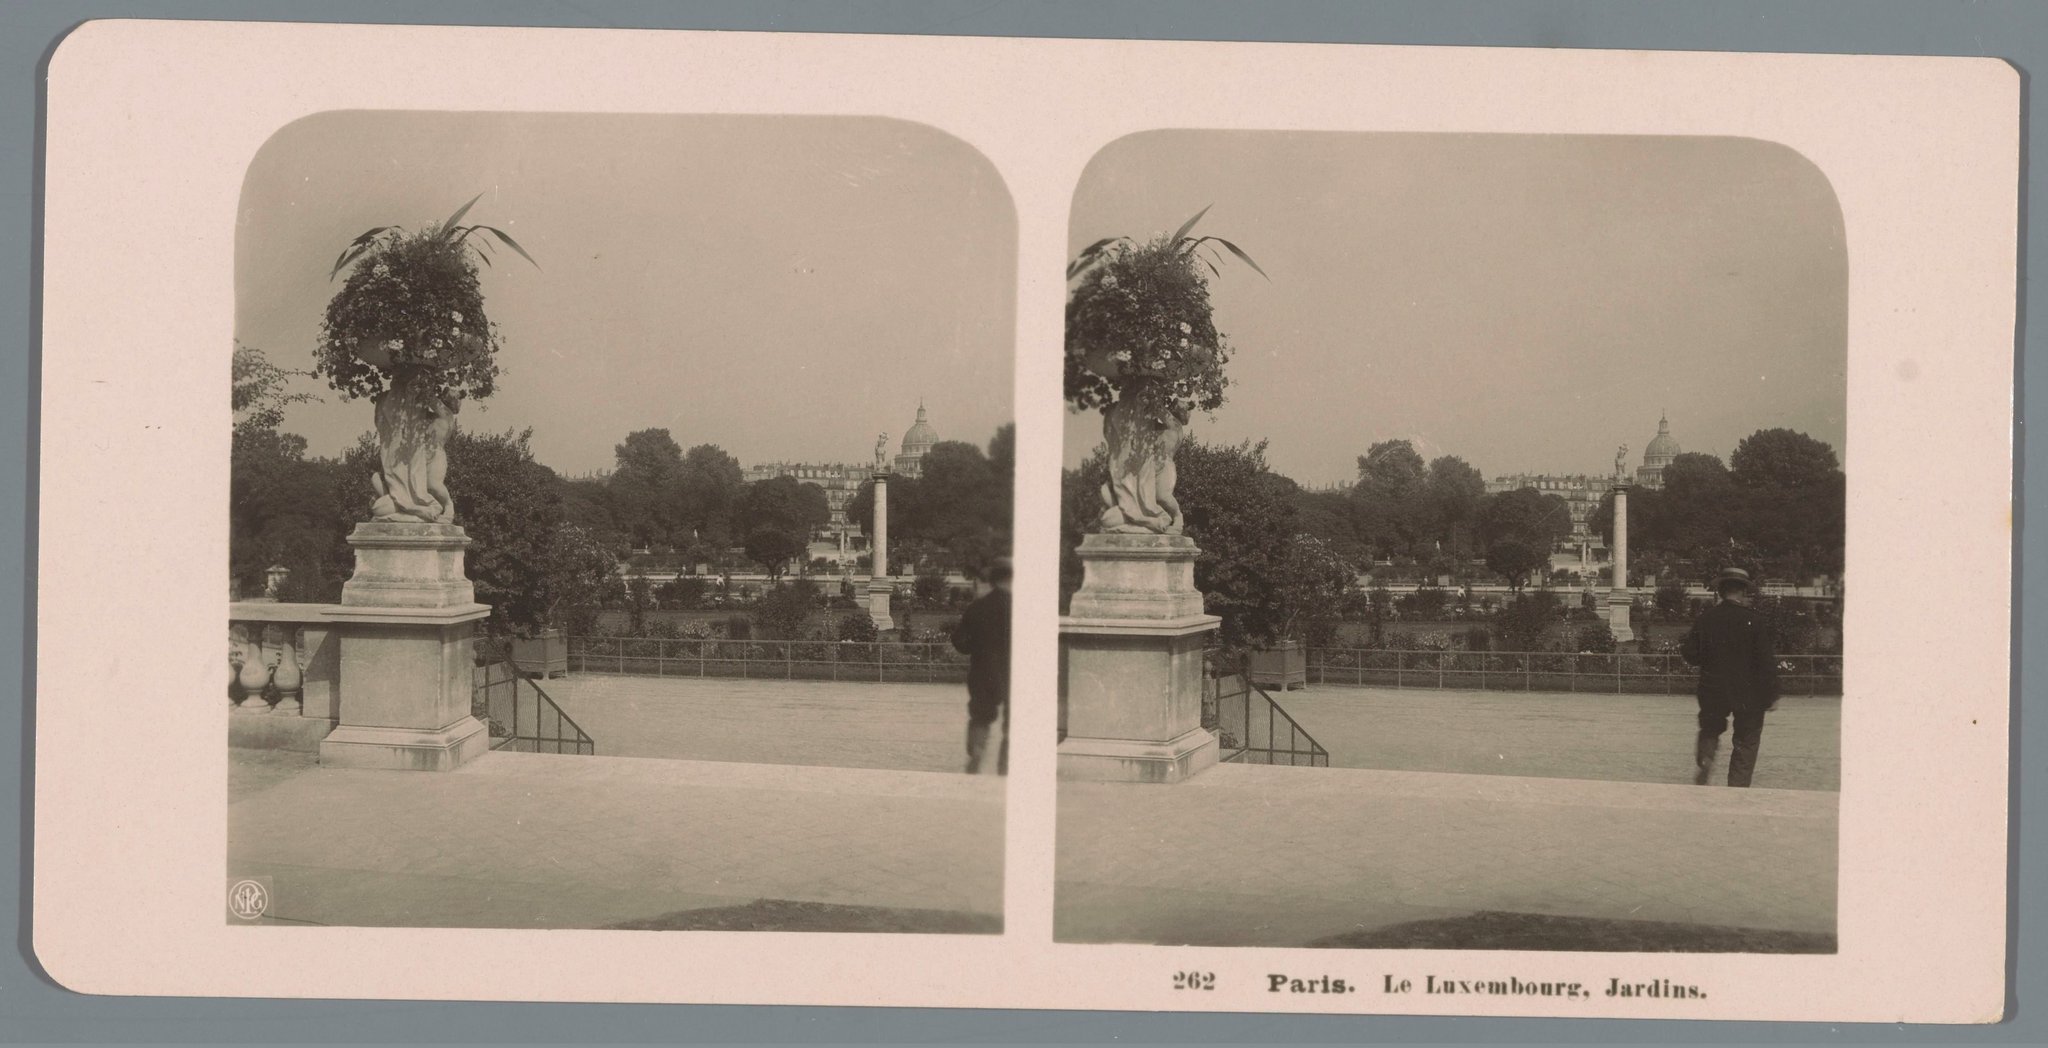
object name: stereograph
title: Gezicht op de Jardin du Luxembourg te Parijs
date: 1895-1905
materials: cardboard, photographic support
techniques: gelatin silver print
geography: paris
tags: park, garden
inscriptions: number: ‘262’, inscription: ‘NPG’